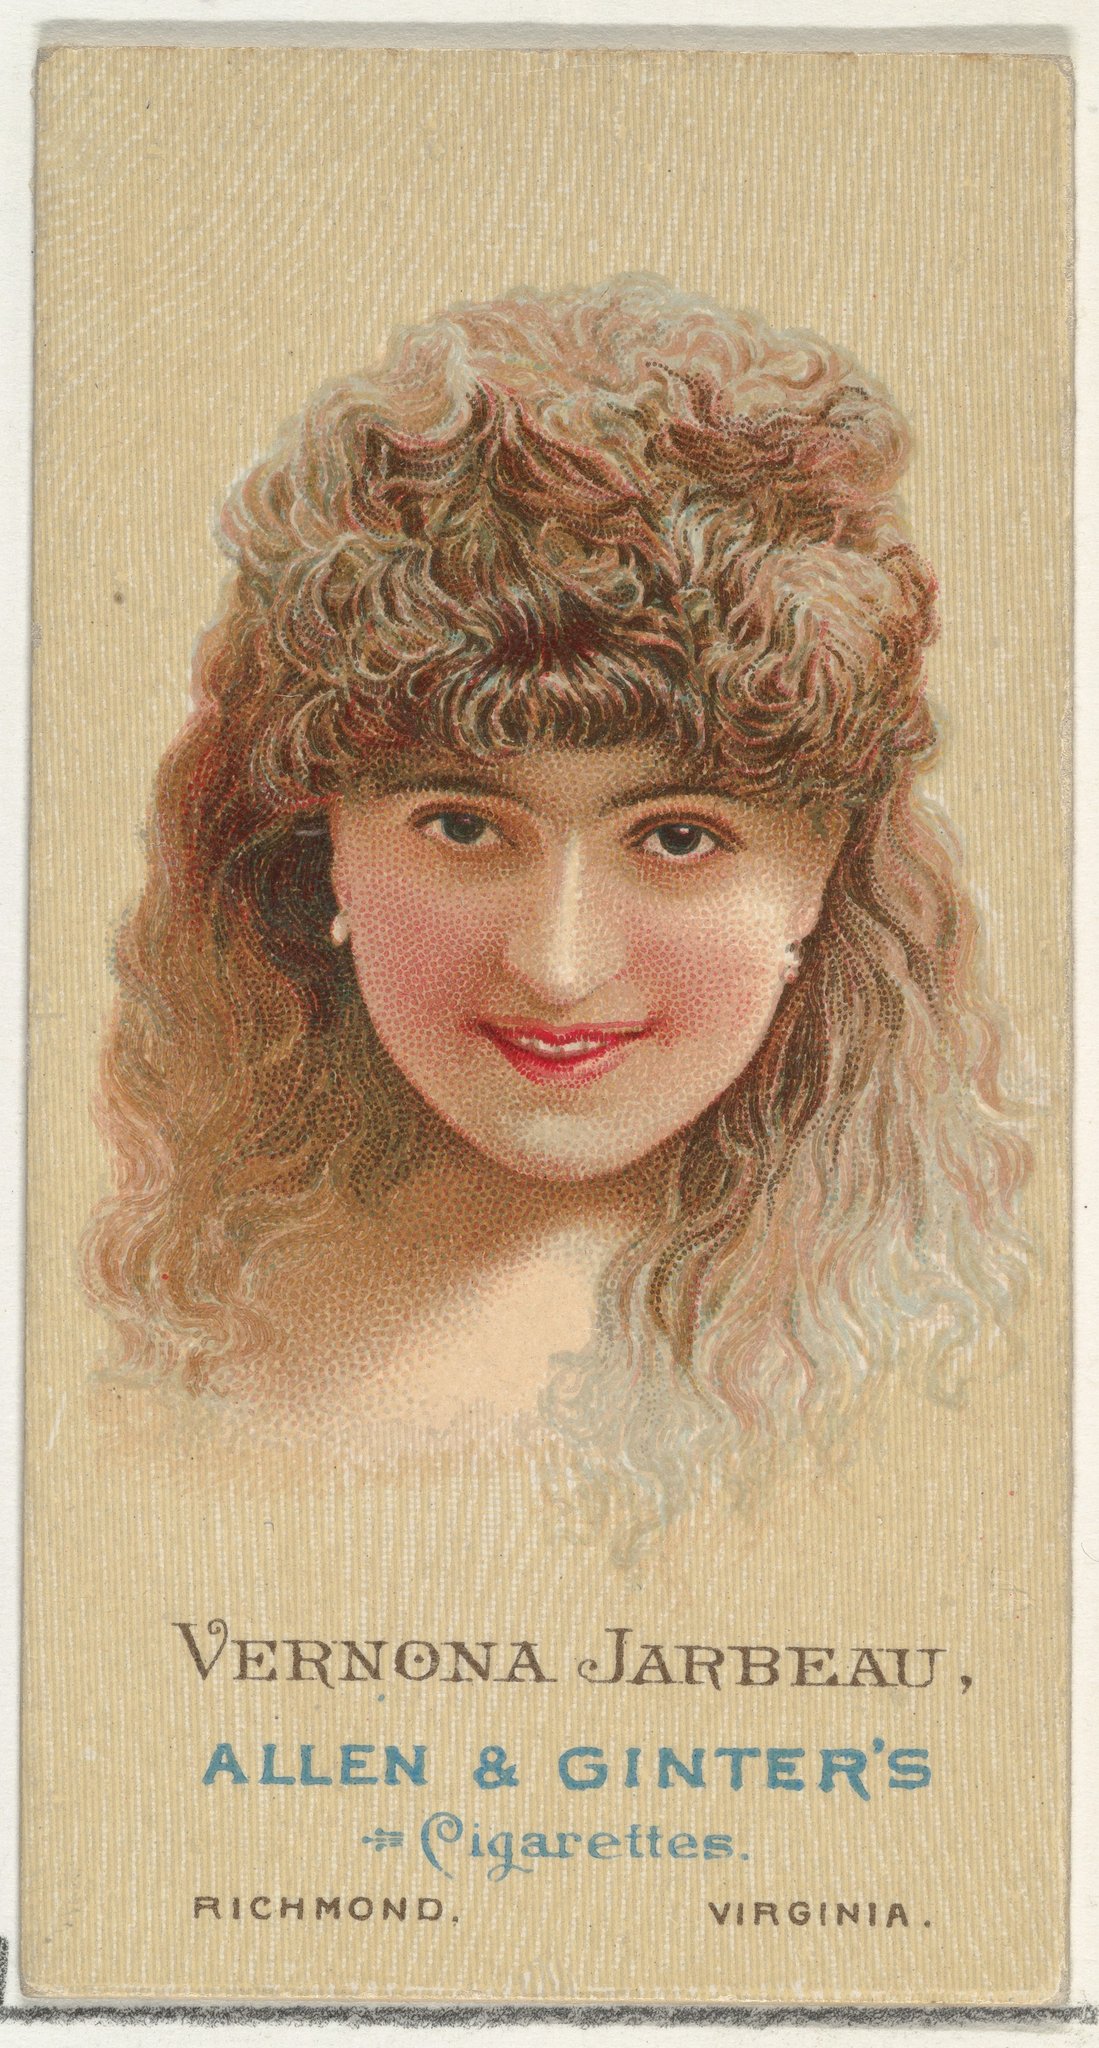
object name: print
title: Vernona Jarbeau, from World's Beauties, Series 2 (N27) for Allen & Ginter Cigarettes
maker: allen & ginter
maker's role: publisher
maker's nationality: american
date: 1888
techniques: color lithograph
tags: women